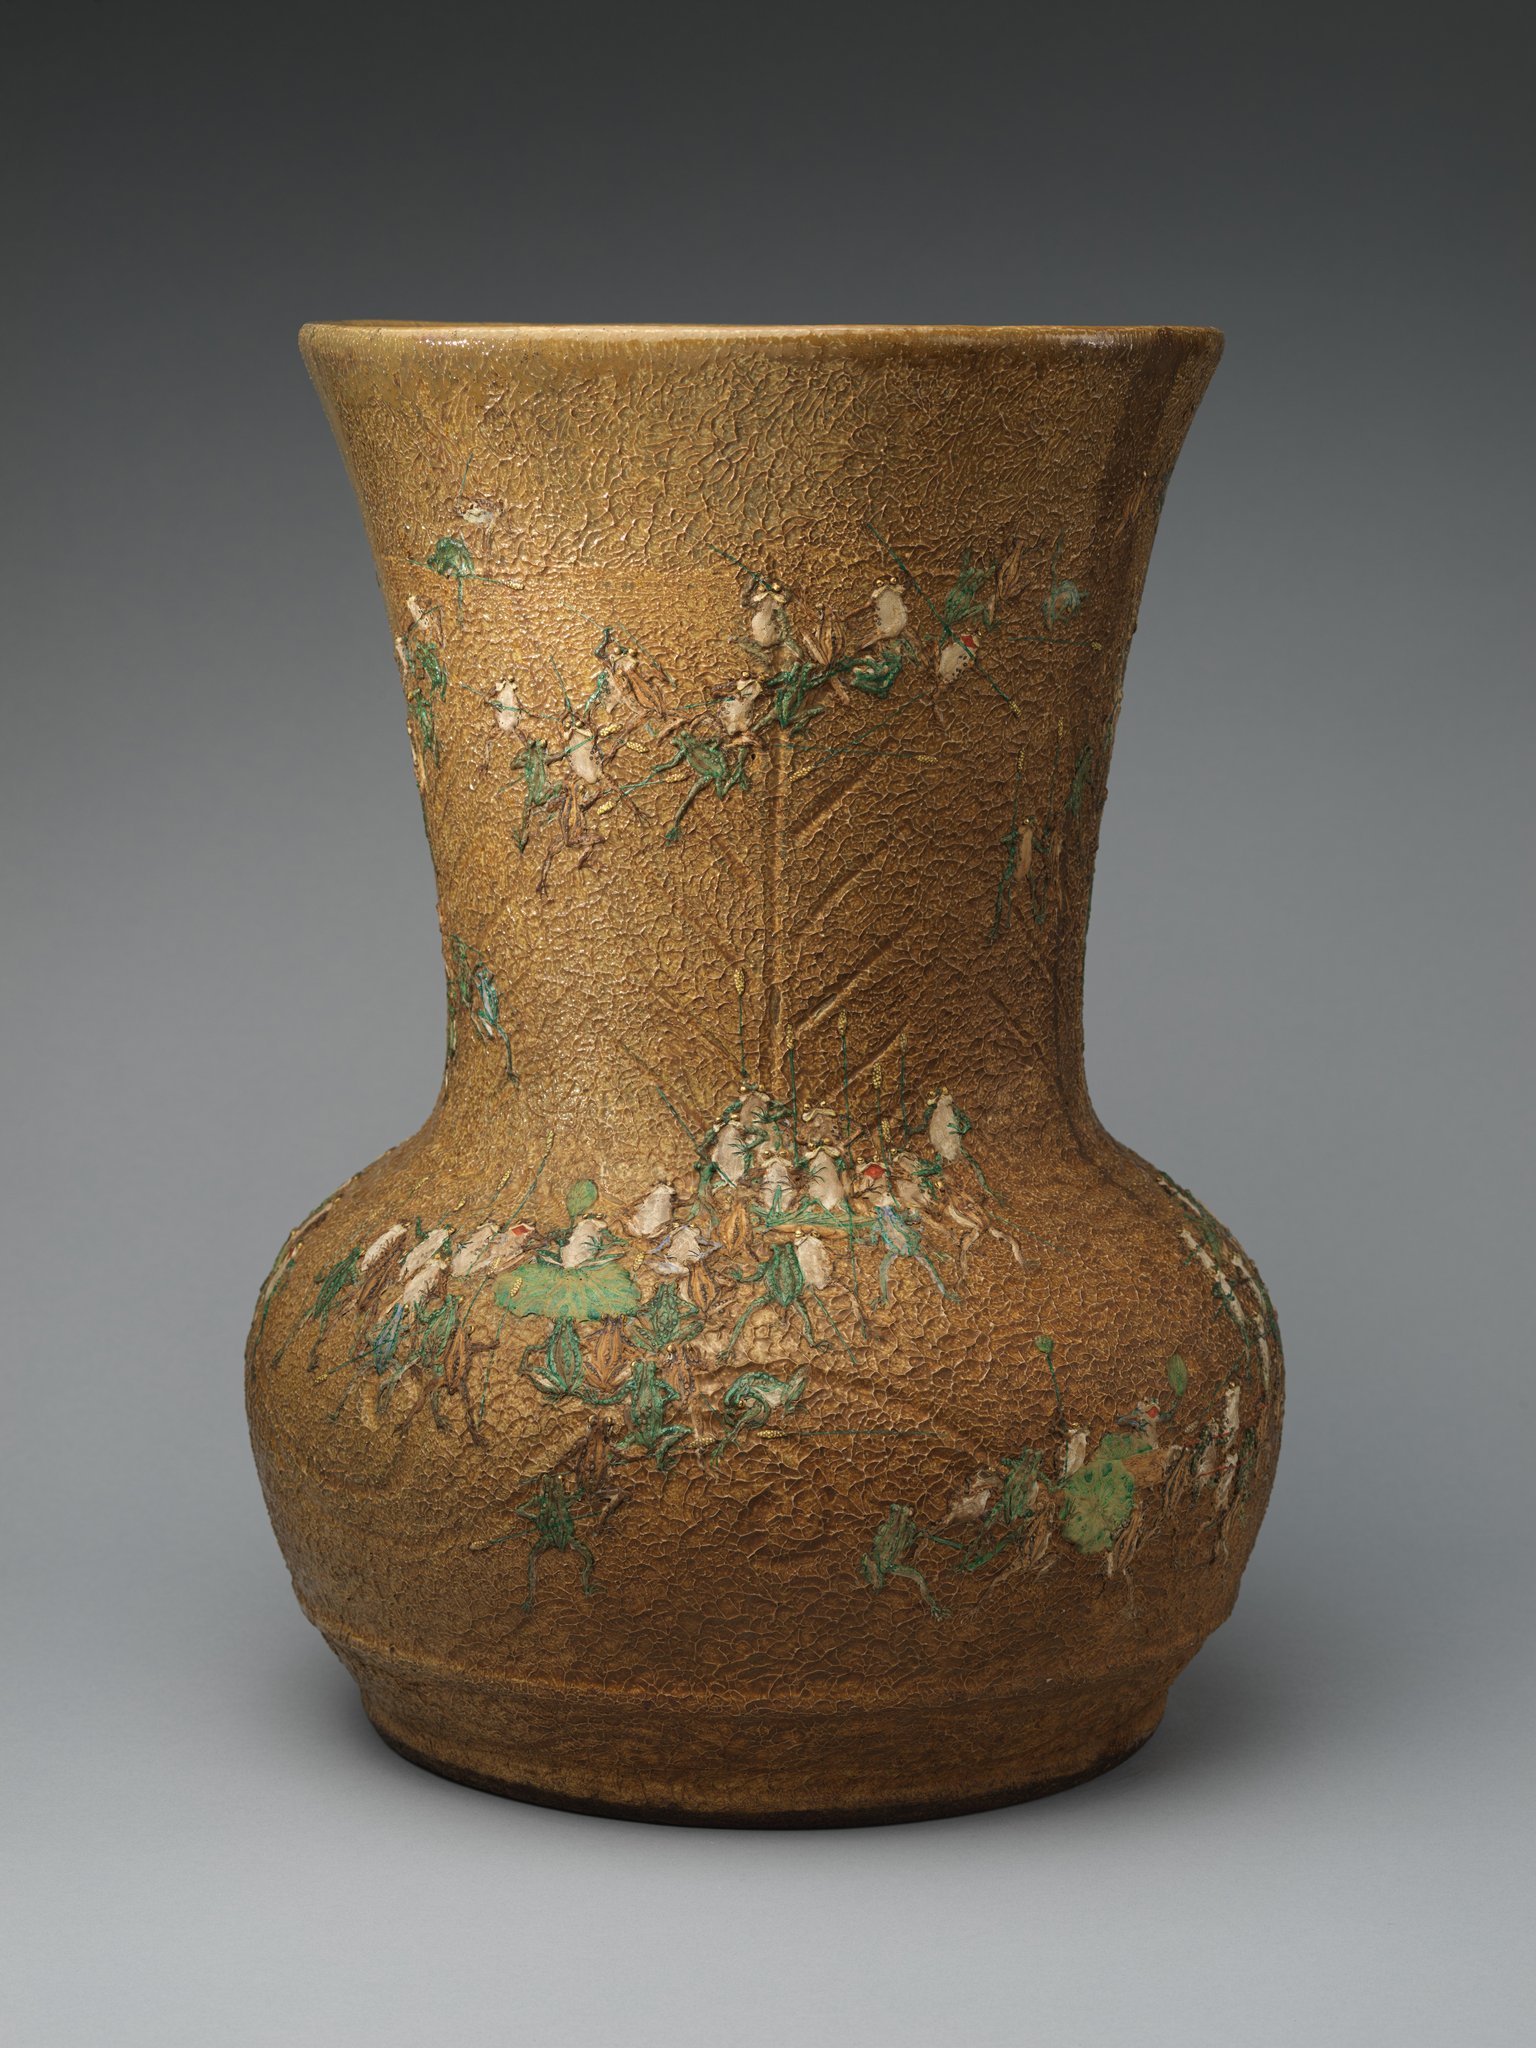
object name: jar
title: Large Jar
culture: japanese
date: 1801-1833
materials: enamel, pottery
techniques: polychrome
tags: frogs